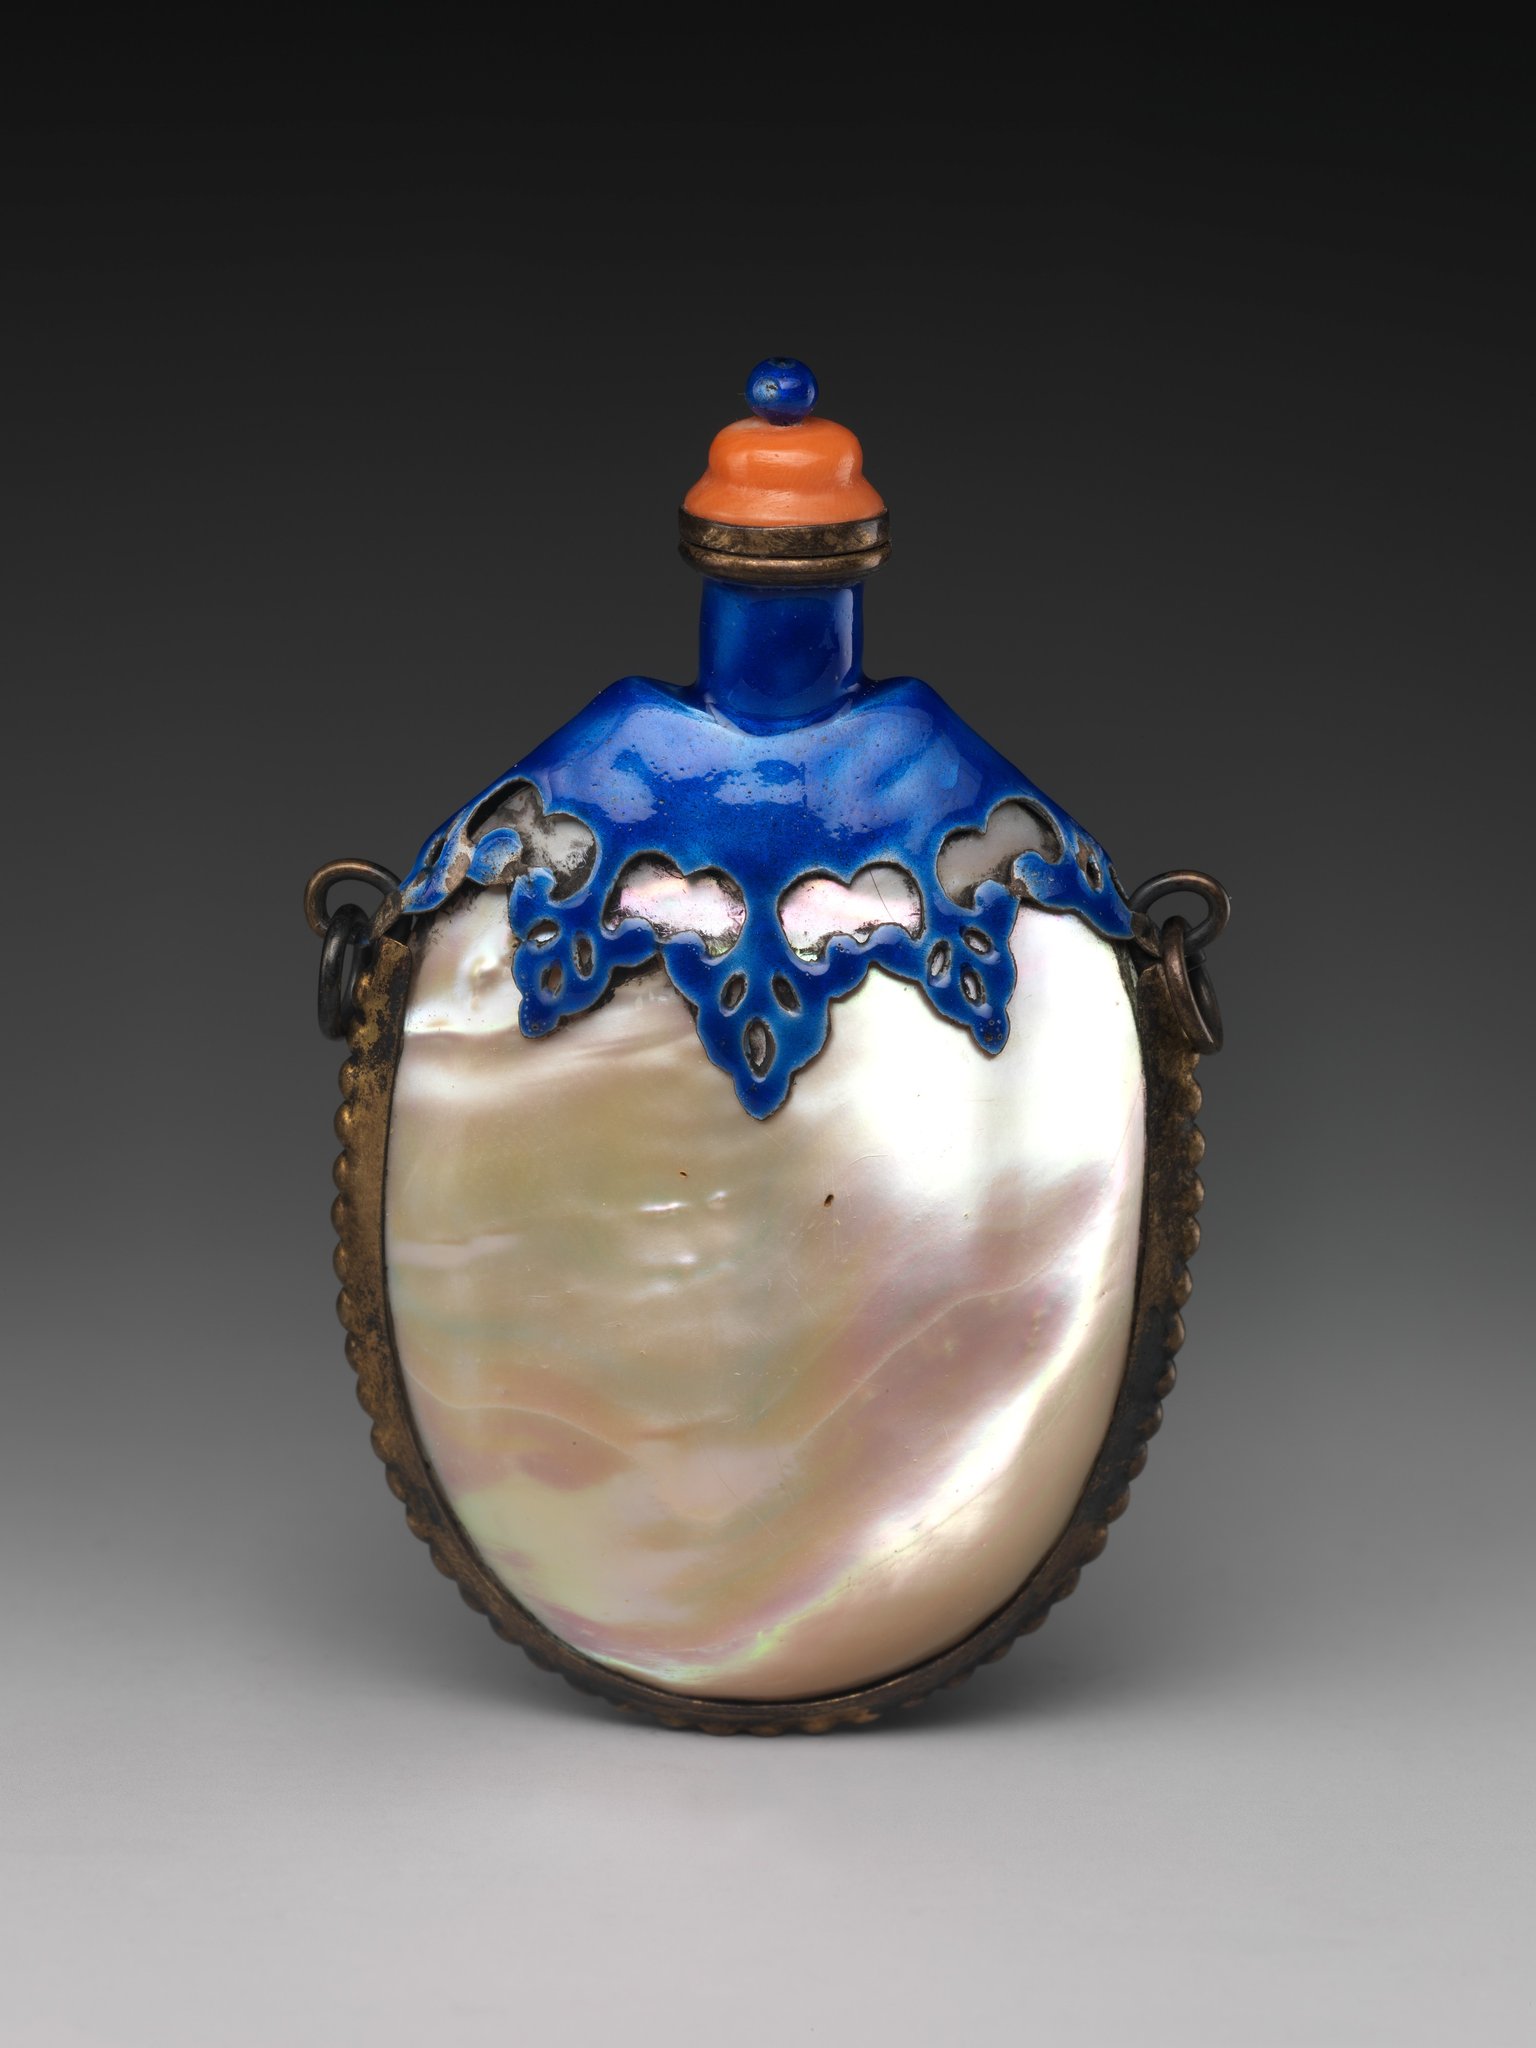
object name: snuff bottle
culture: chinese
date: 1801-1900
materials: brass, enamel, glass, mother of pearl, shell